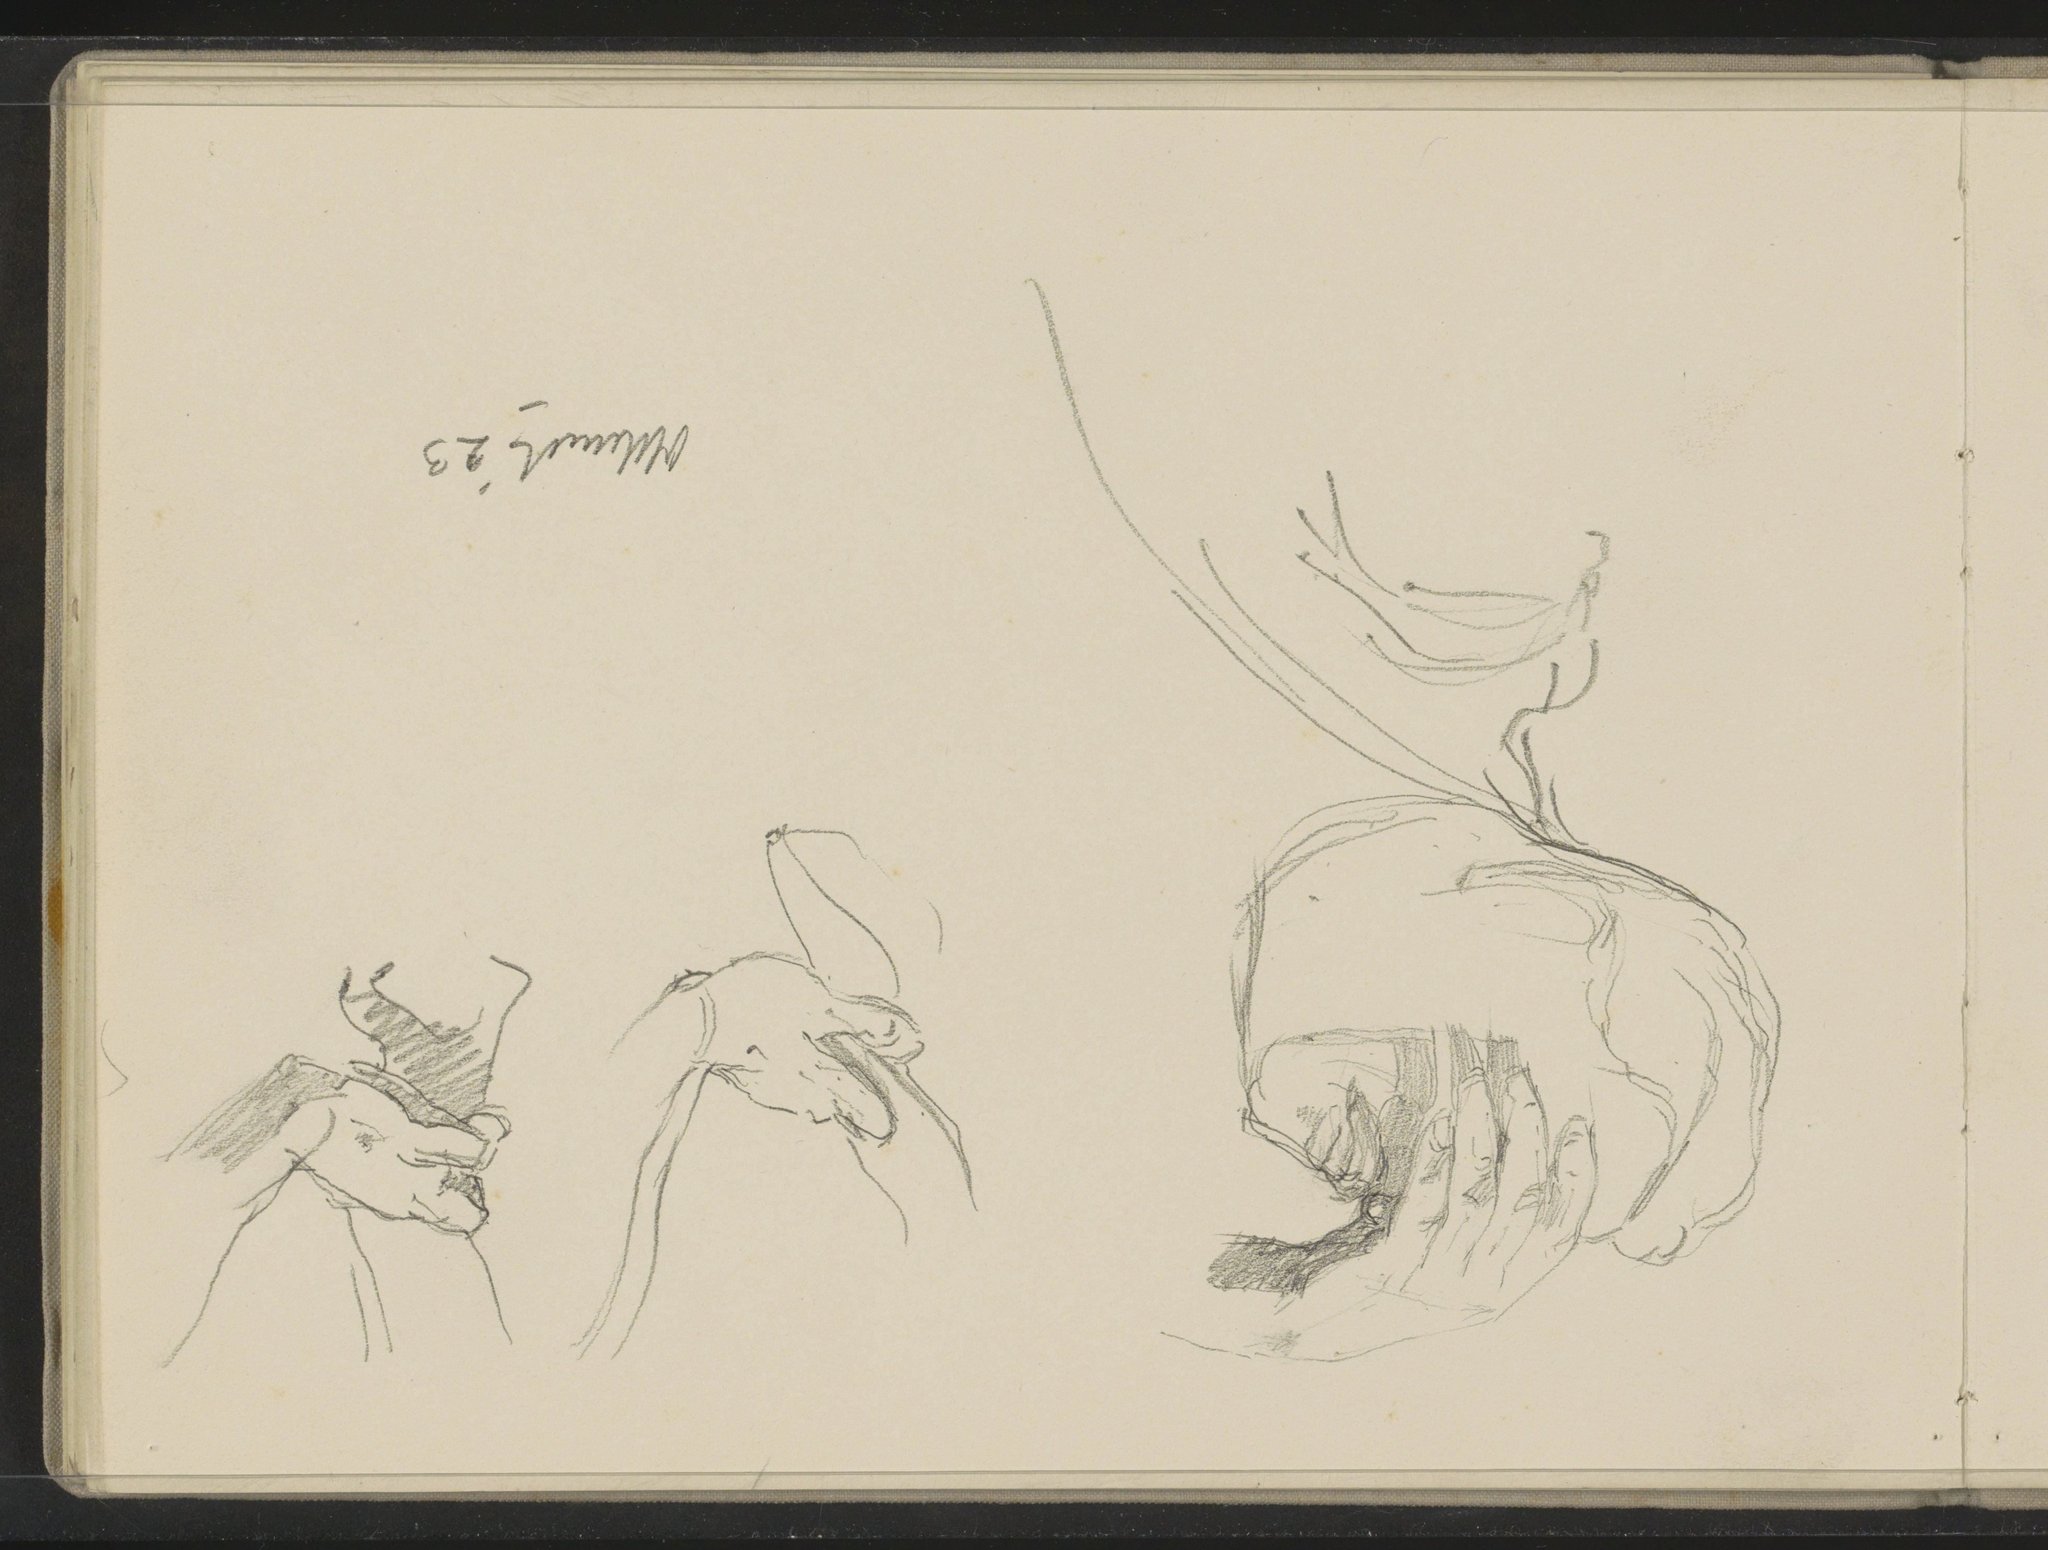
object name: sketchbook leaf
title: Man met hand over de ogen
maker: ferdinand oldewelt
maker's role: draughtsman, print maker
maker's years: 1857-1935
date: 1908-1923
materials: paper, pencil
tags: hand(s) towards the eye(s)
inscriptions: signature and date: ‘Oldewelt '23’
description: Tevens studies van handen. Blad 30 verso uit een schetsboek met 35 bladen.